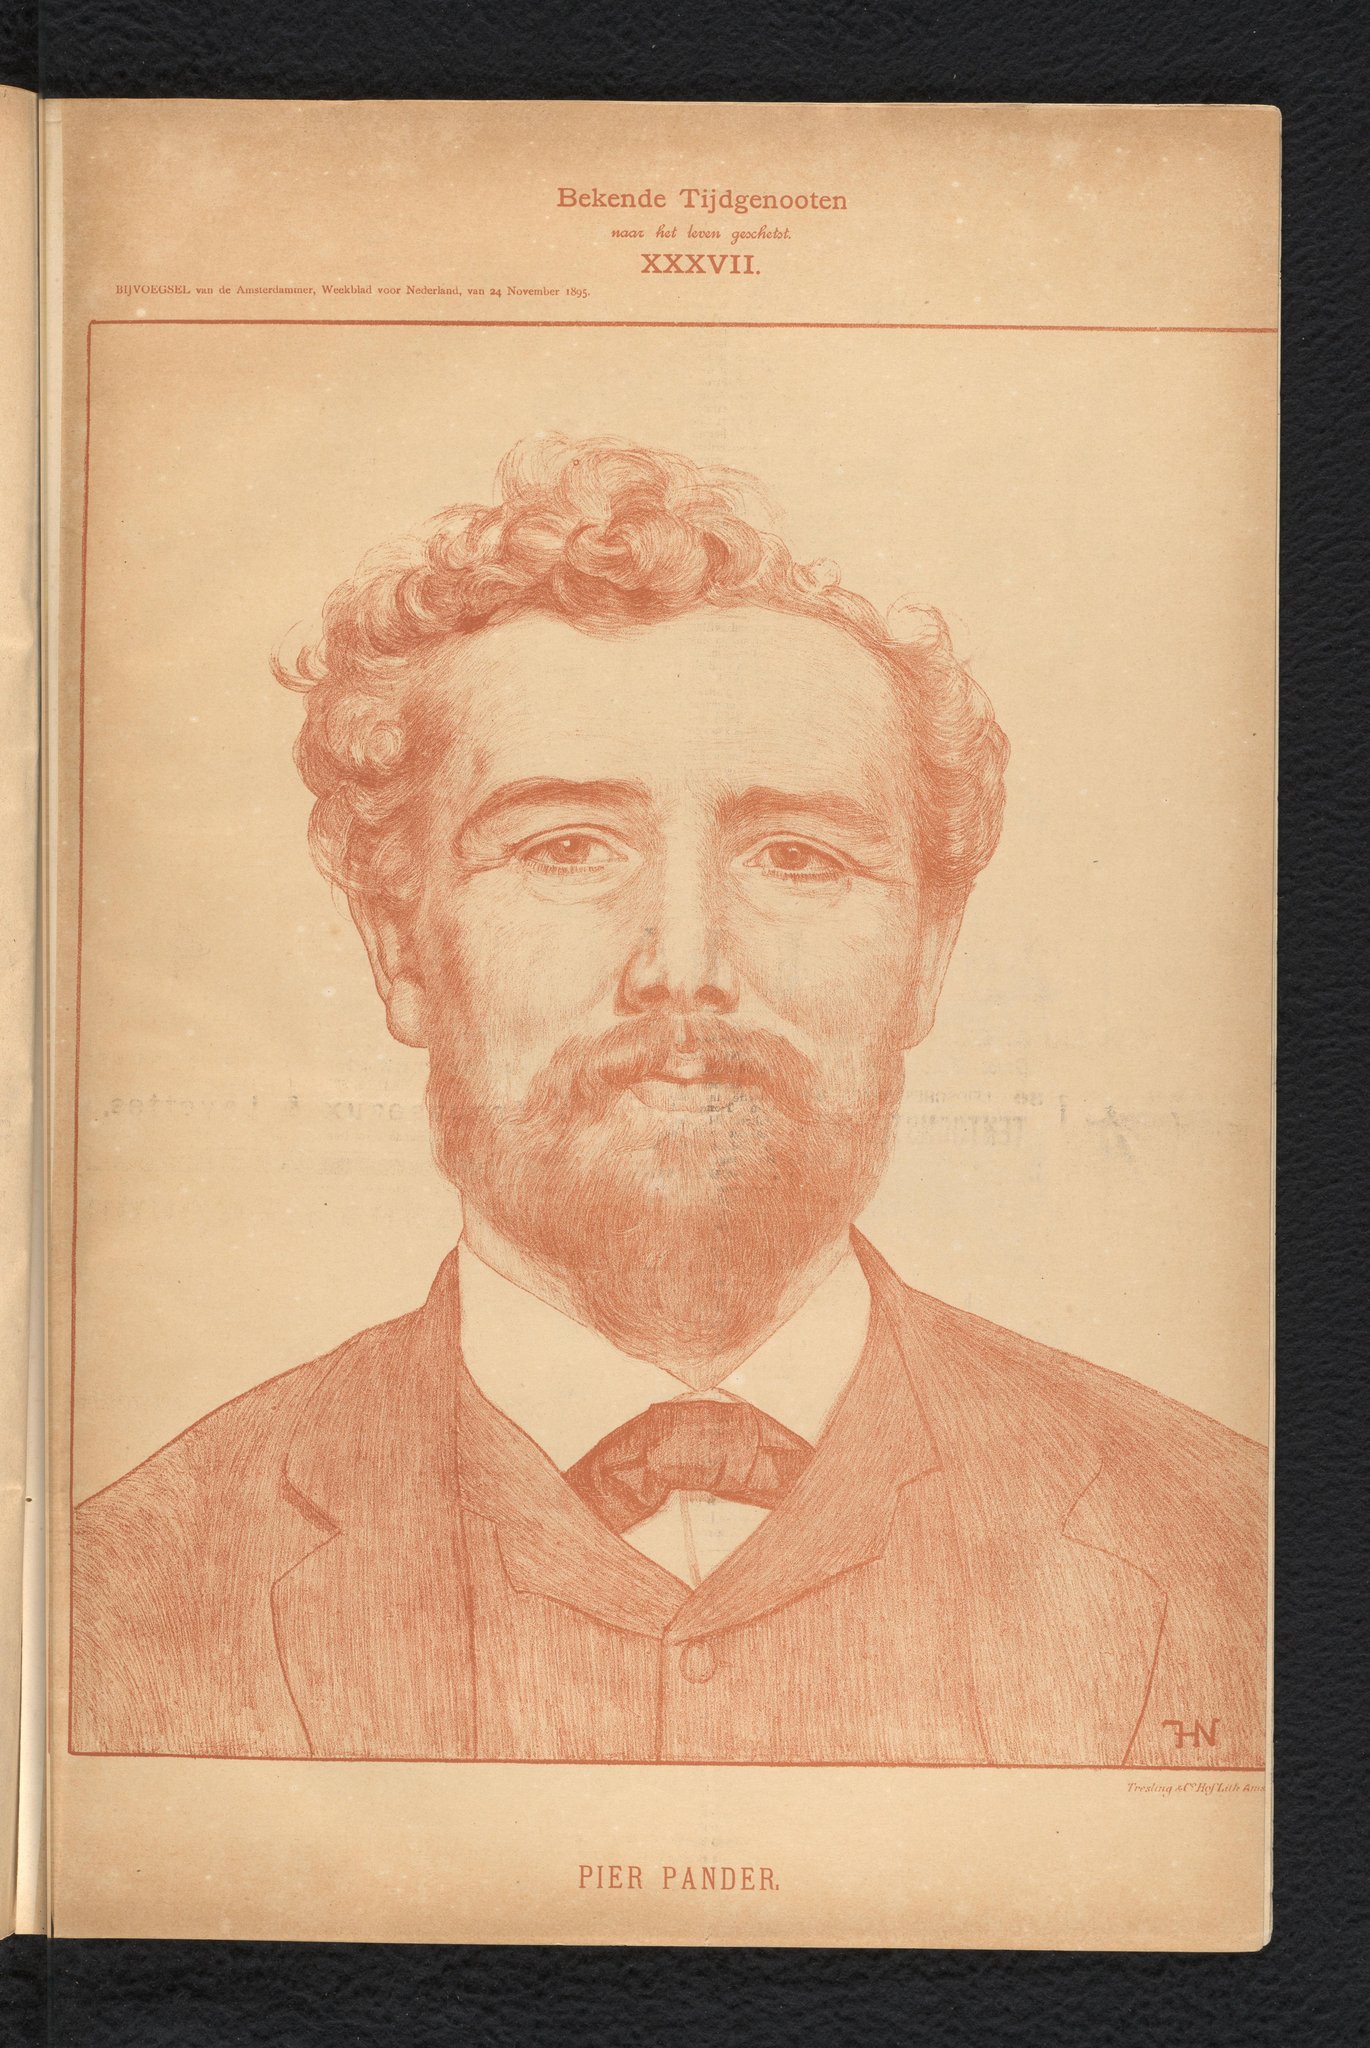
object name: print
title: Portret van Pier Pander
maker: ferdinand hart nibbrig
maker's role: draughtsman, painter, print maker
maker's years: 1866-1915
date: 1895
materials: paper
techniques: lithograph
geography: netherlands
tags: rome, draughtsman, designer, sculptor, pier pander, historical persons, portrait, self-portrait of artist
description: Portret van de kunstenaar Pier Pander. In de serie 'Bekende Tijdgenooten', nr. XXXVII.